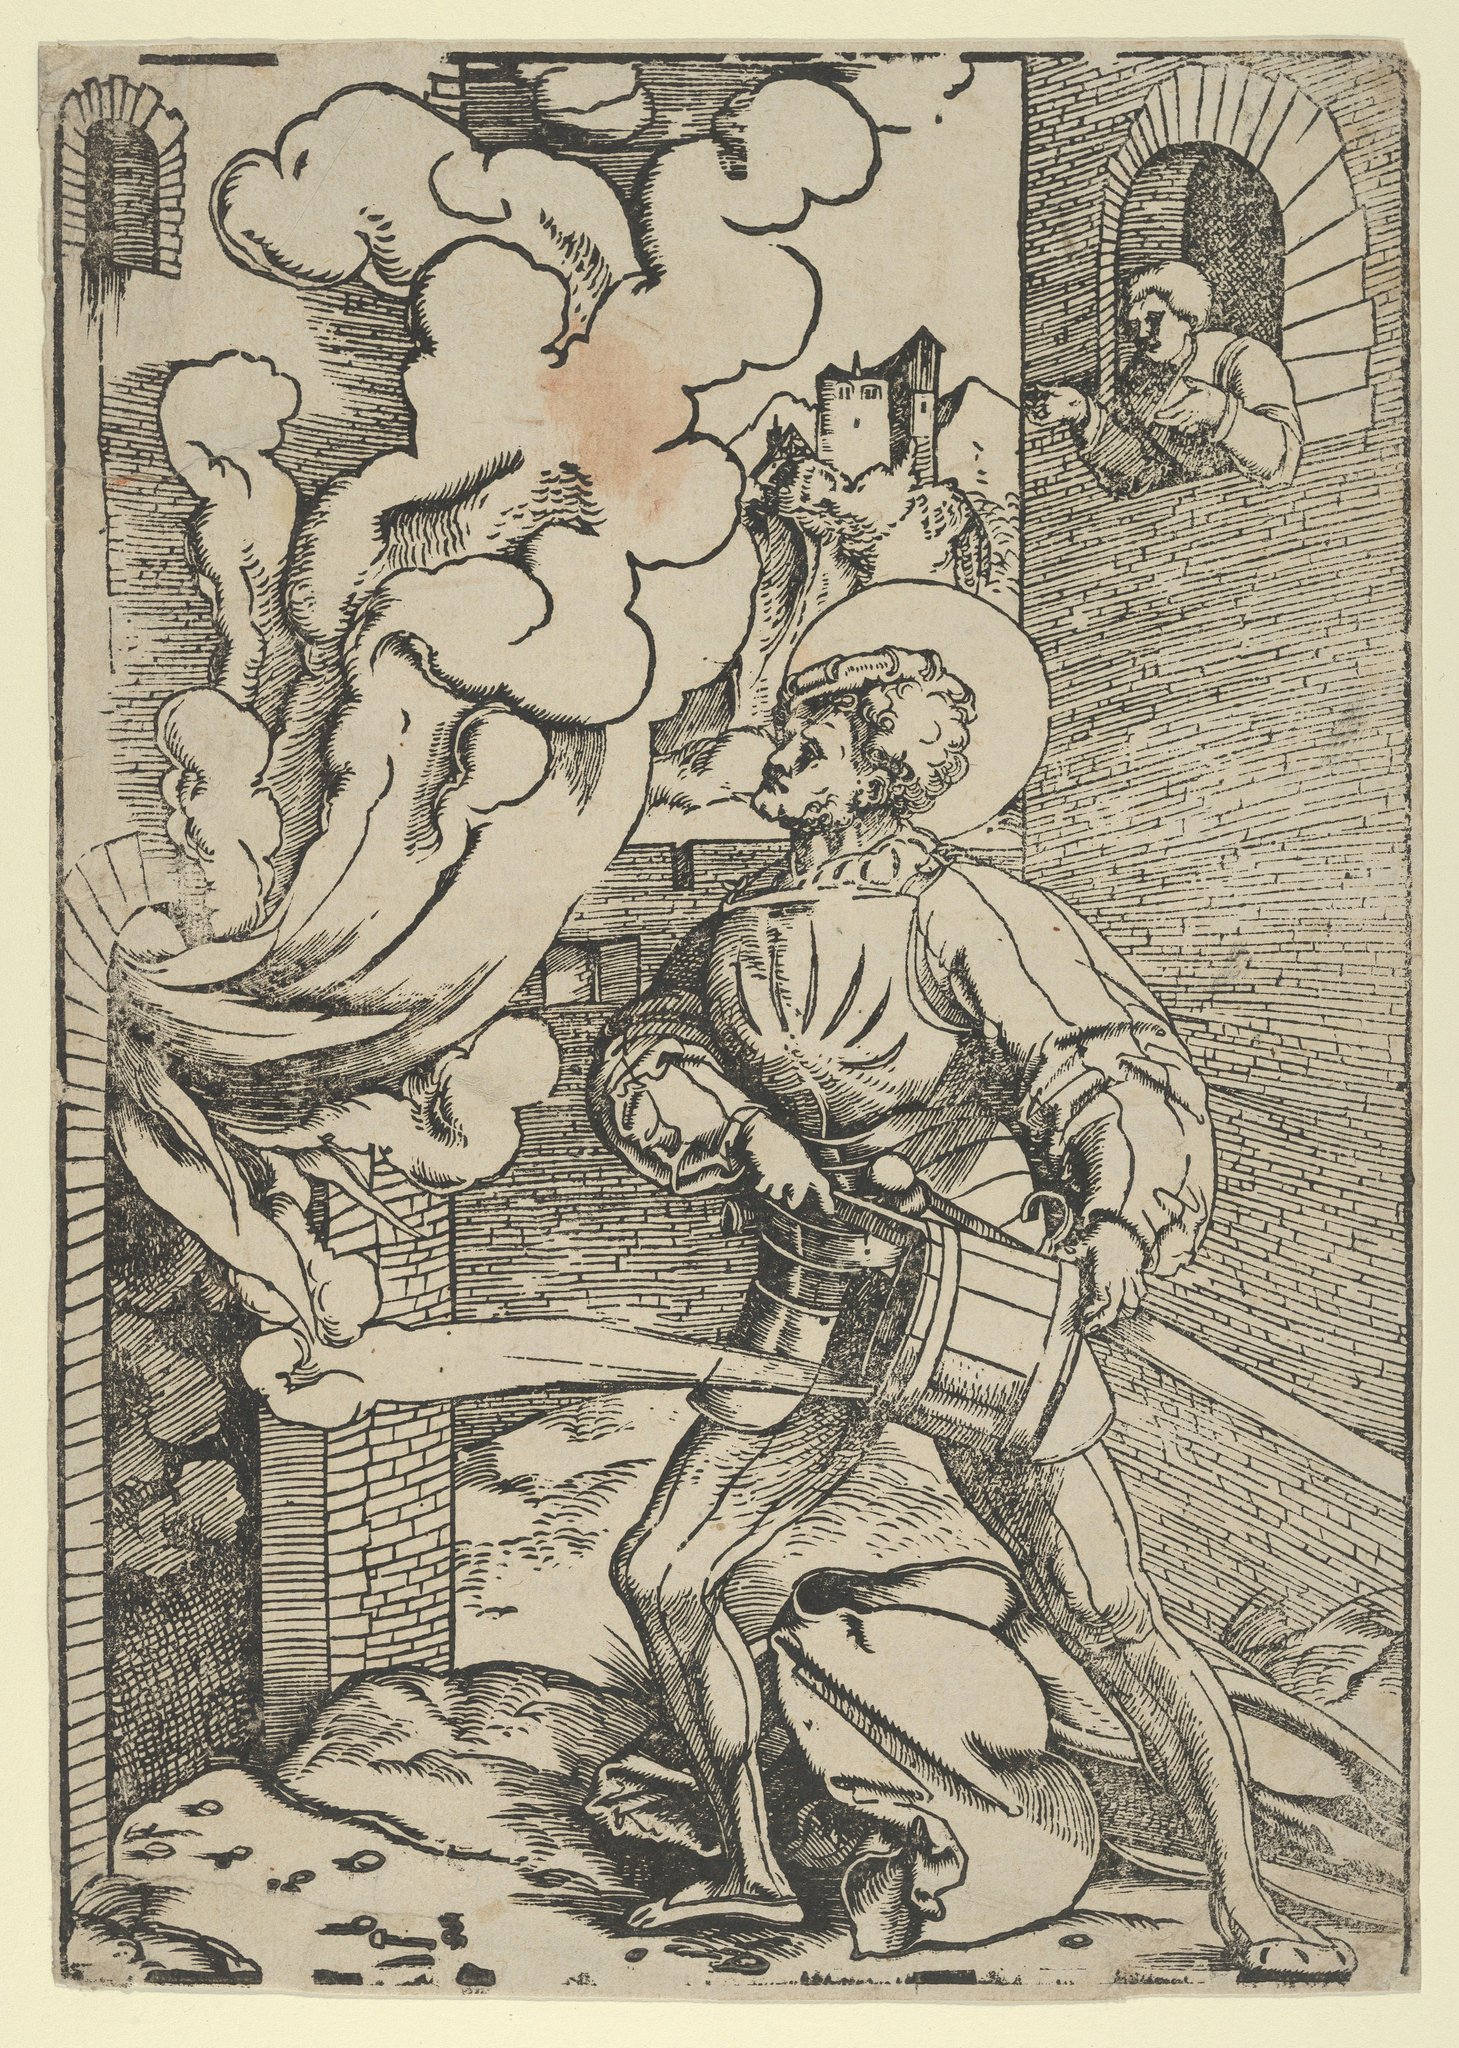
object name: print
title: Saint Florian (restrike)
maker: hans schäufelein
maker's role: artist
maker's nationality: german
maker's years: 1480-1540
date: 1500-1540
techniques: woodcut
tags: men,saints